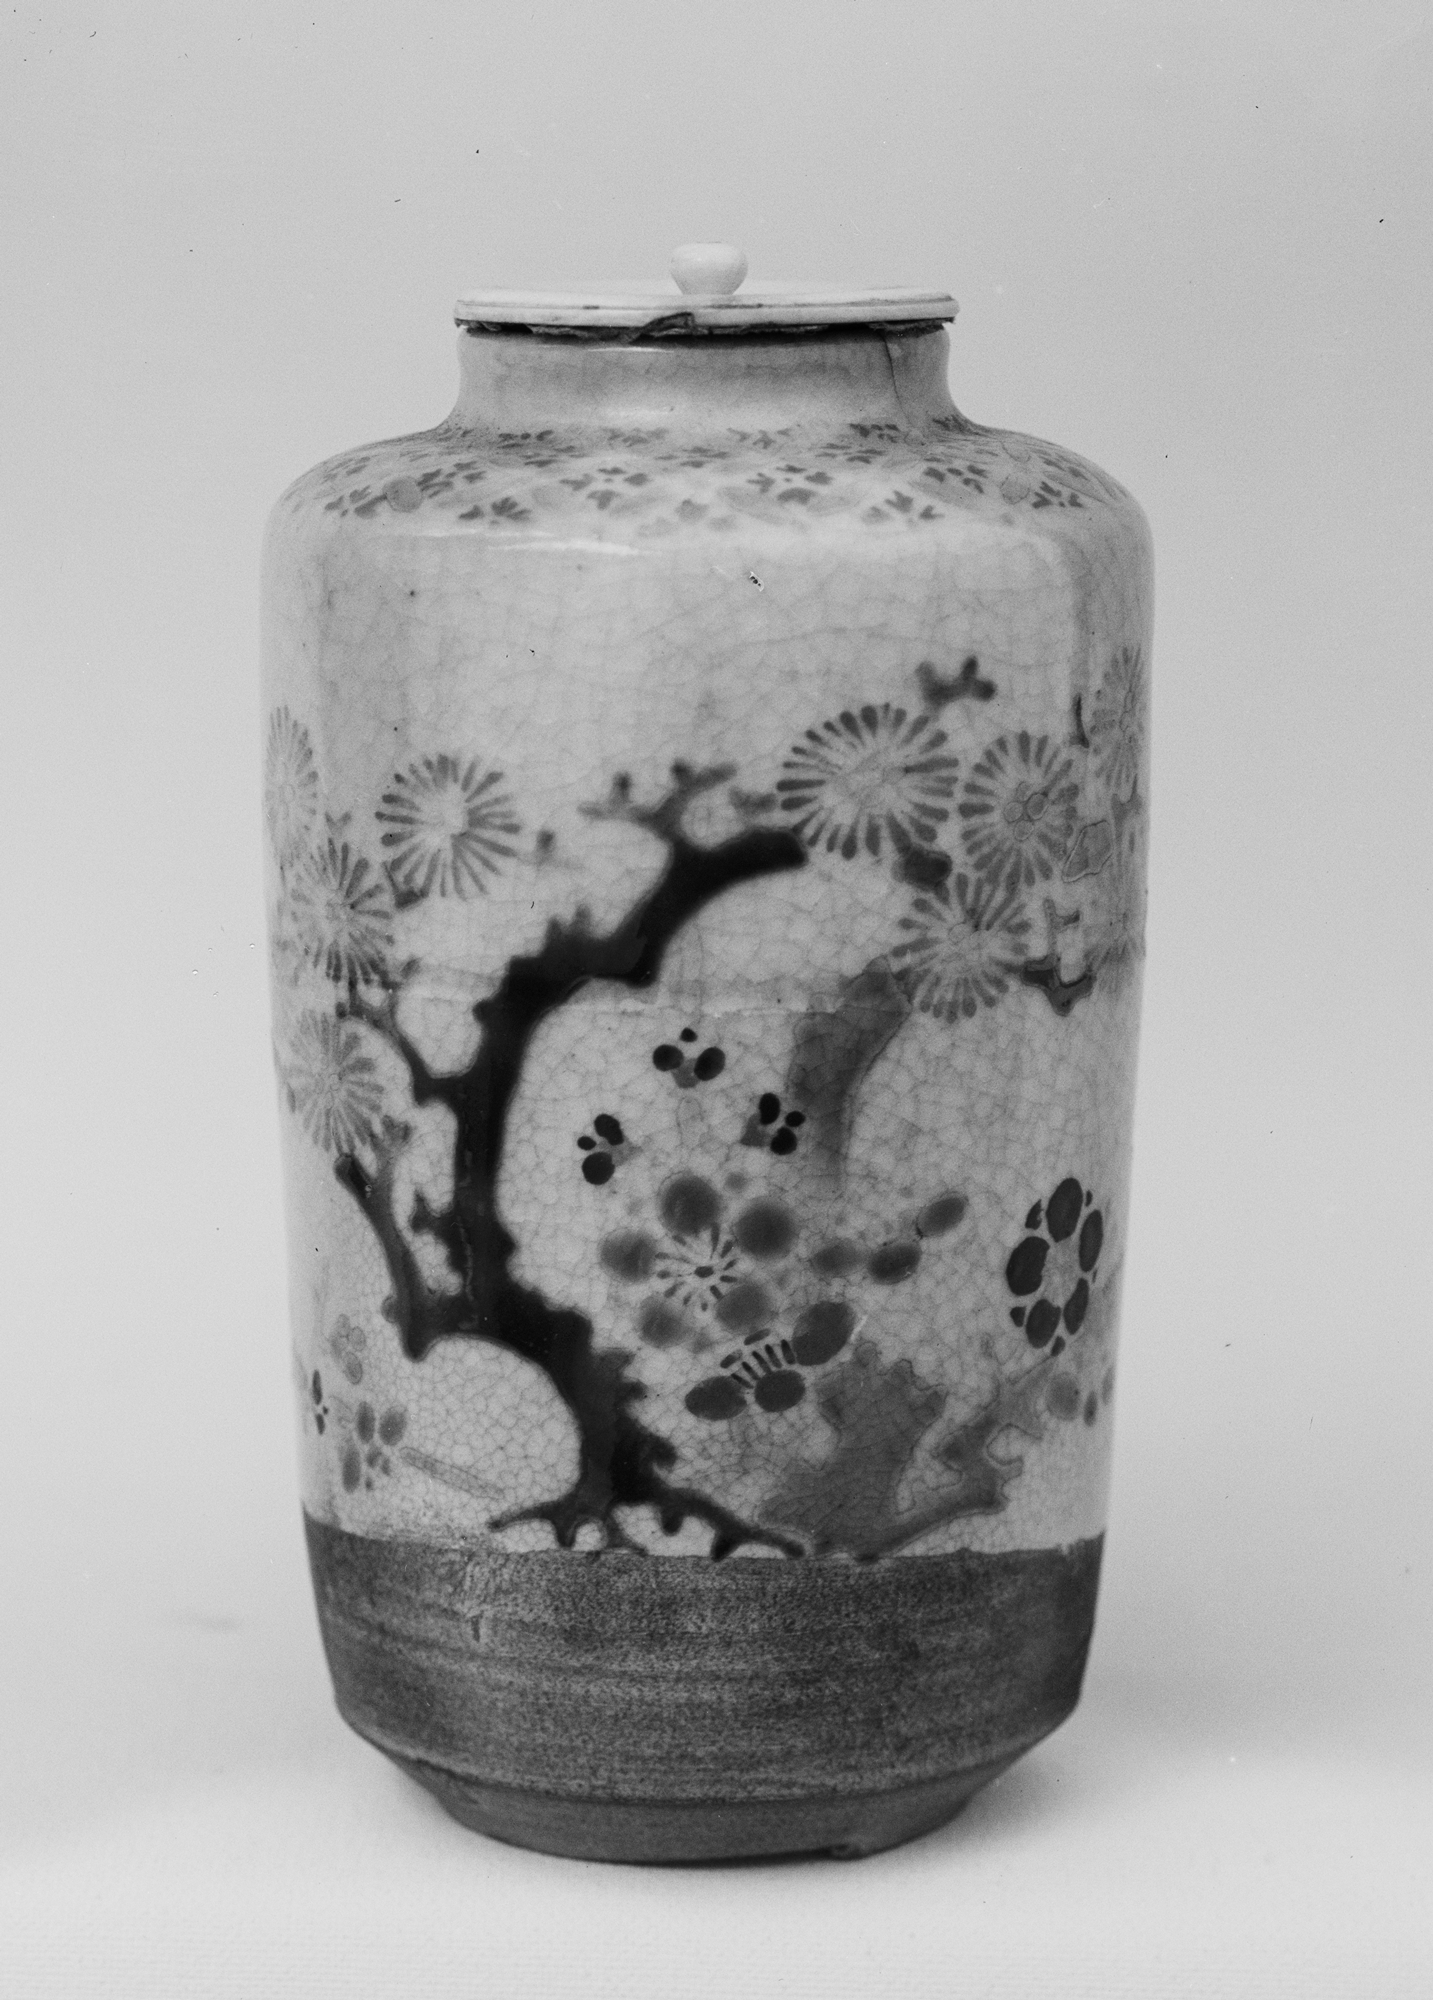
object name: tea jar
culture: japanese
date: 1780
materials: clay, enamel, glaze, gold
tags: flowers